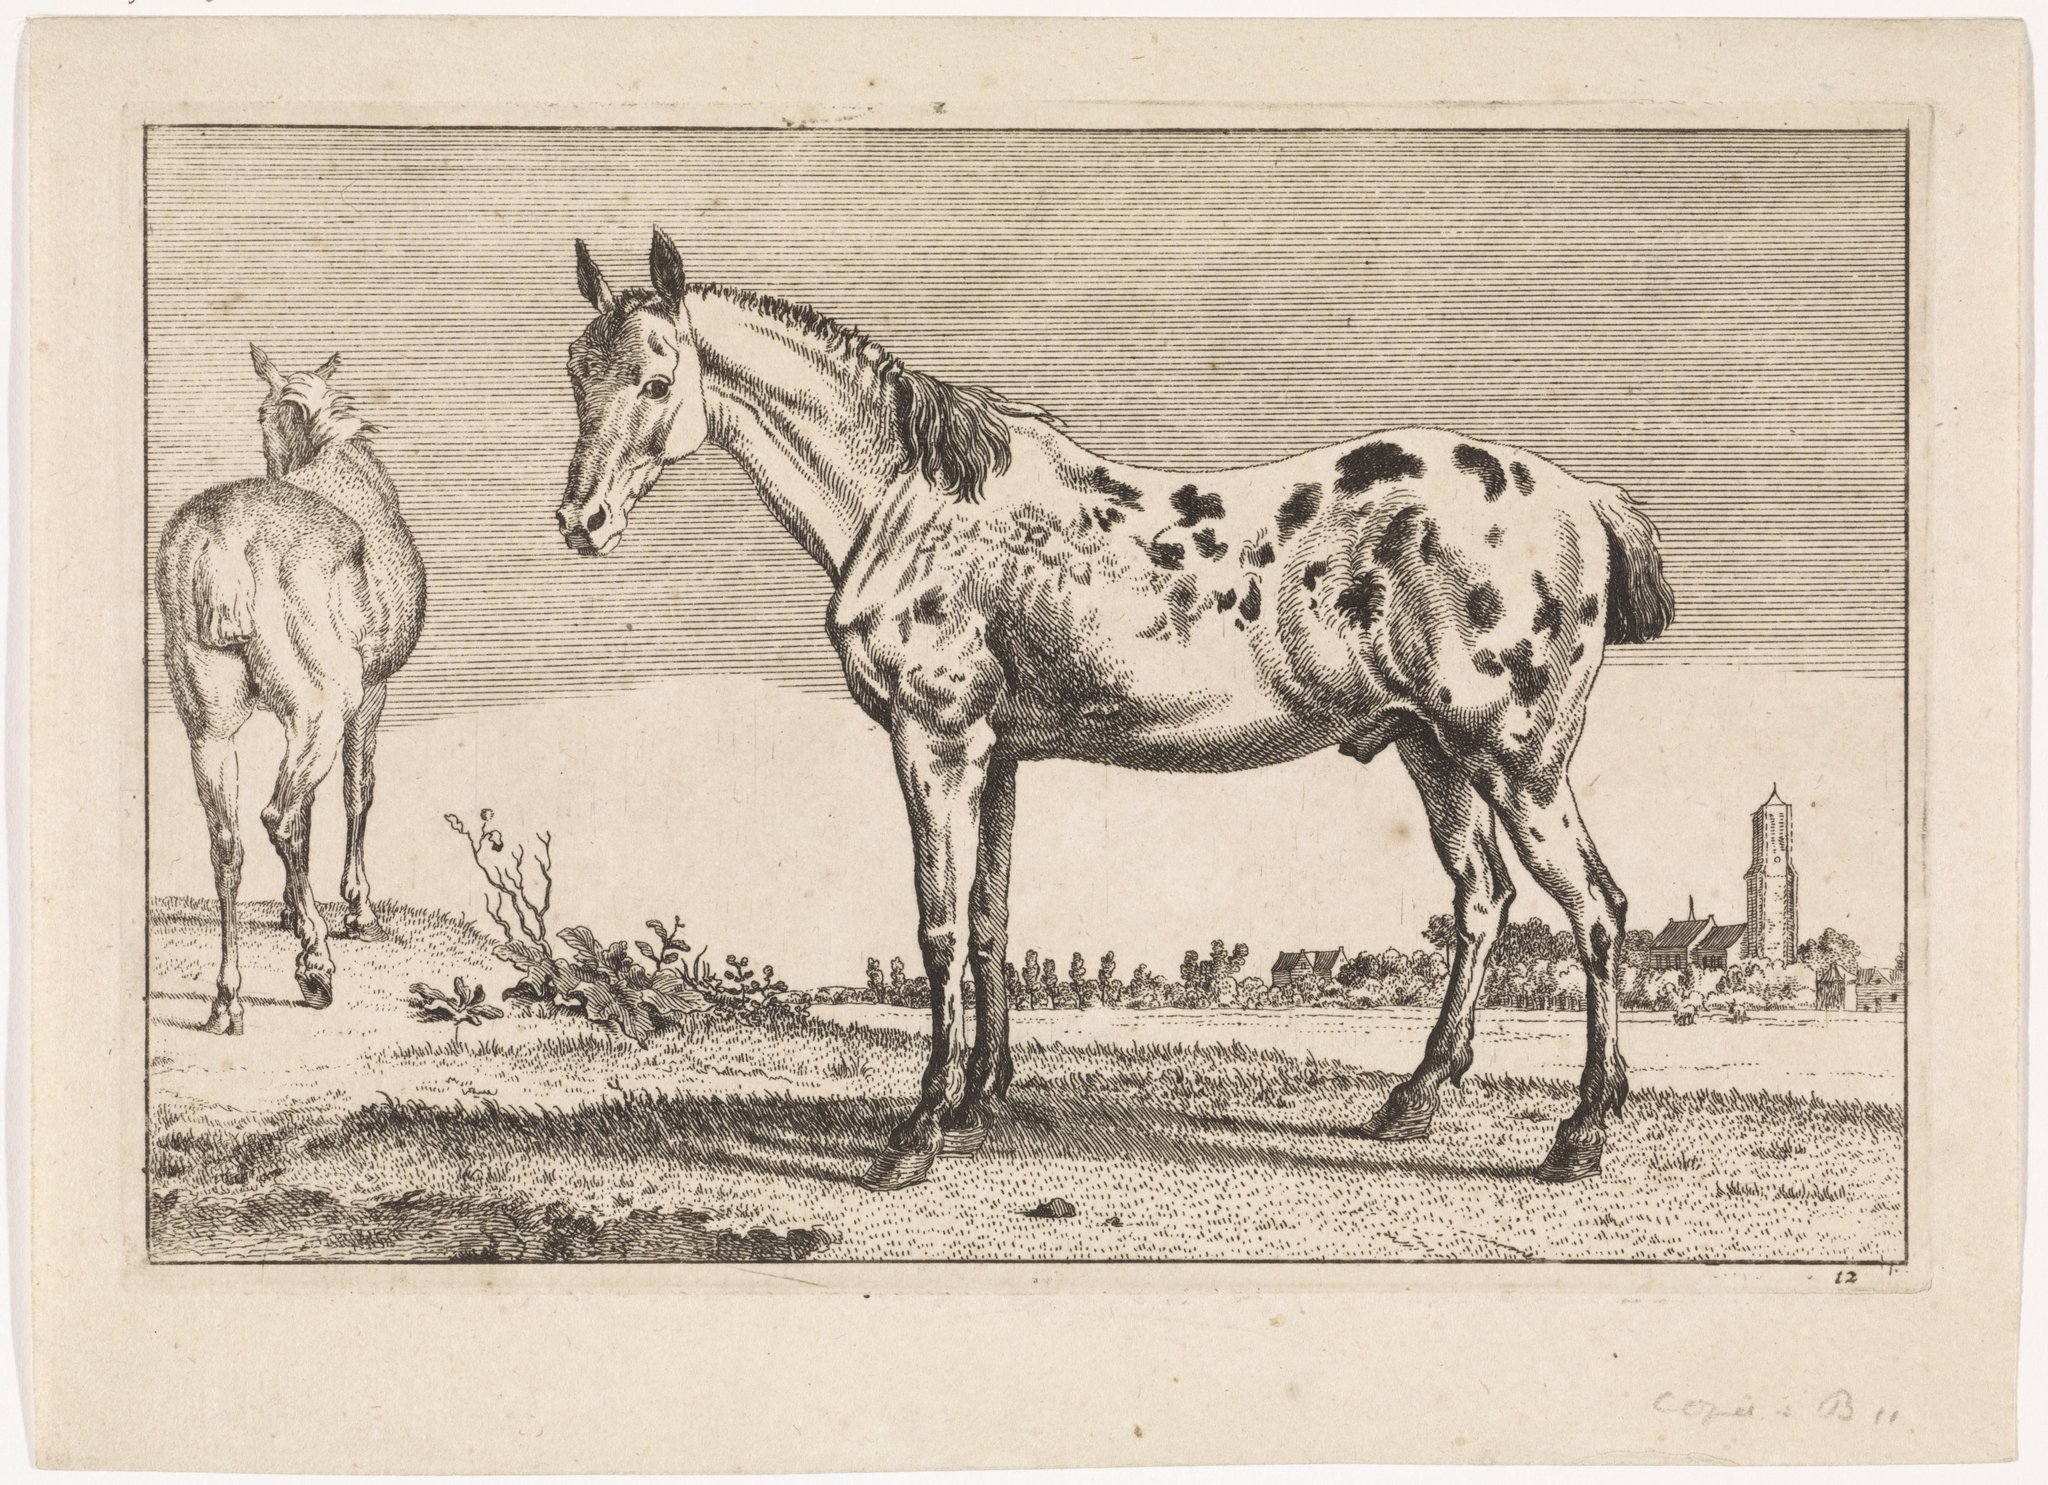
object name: print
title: Het gecoupeerde paard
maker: Anonymous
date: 1652-1702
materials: paper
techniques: etching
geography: netherlands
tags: man and animal (+ docking an animal), horse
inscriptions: collector's mark: Lugt 2228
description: Een gevlekt paard met een gecoupeerde staart, van de zijkant gezien, en een paard van achteren gezien. Rechtsonder genummerd: 12.